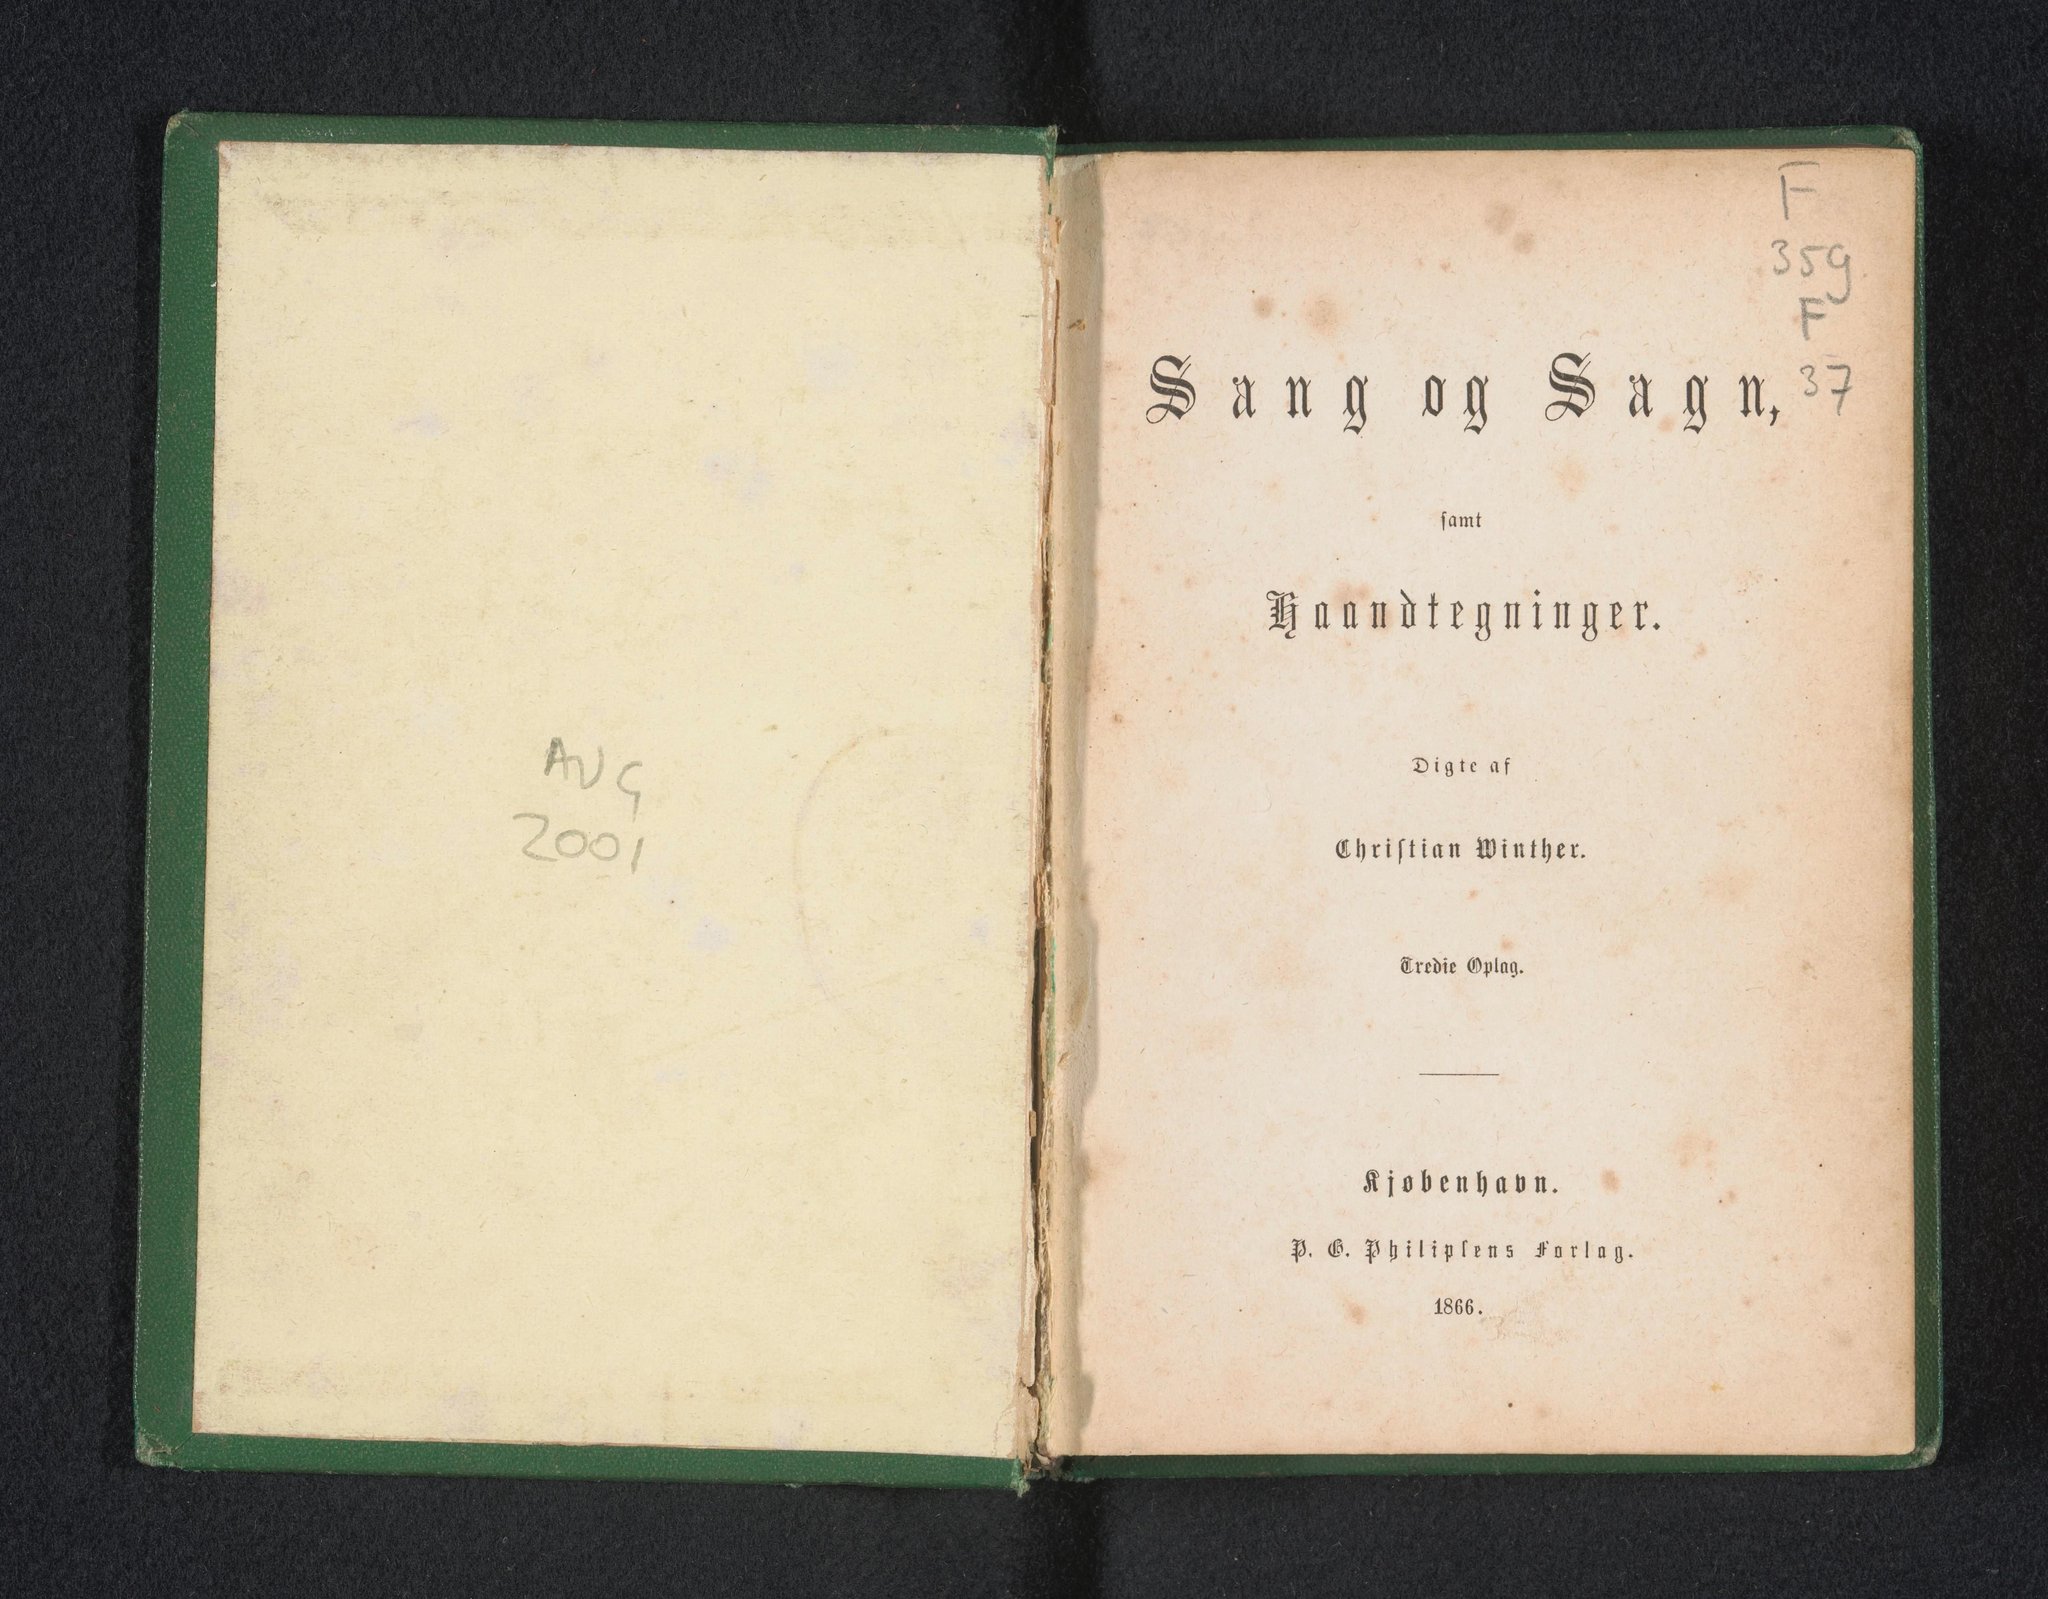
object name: book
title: Sang og sagn, samt haandtegninger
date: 1866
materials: cardboard, paper, textile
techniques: albumen print, printing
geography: copenhagen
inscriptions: annotation: ‘AUG/ 2001’